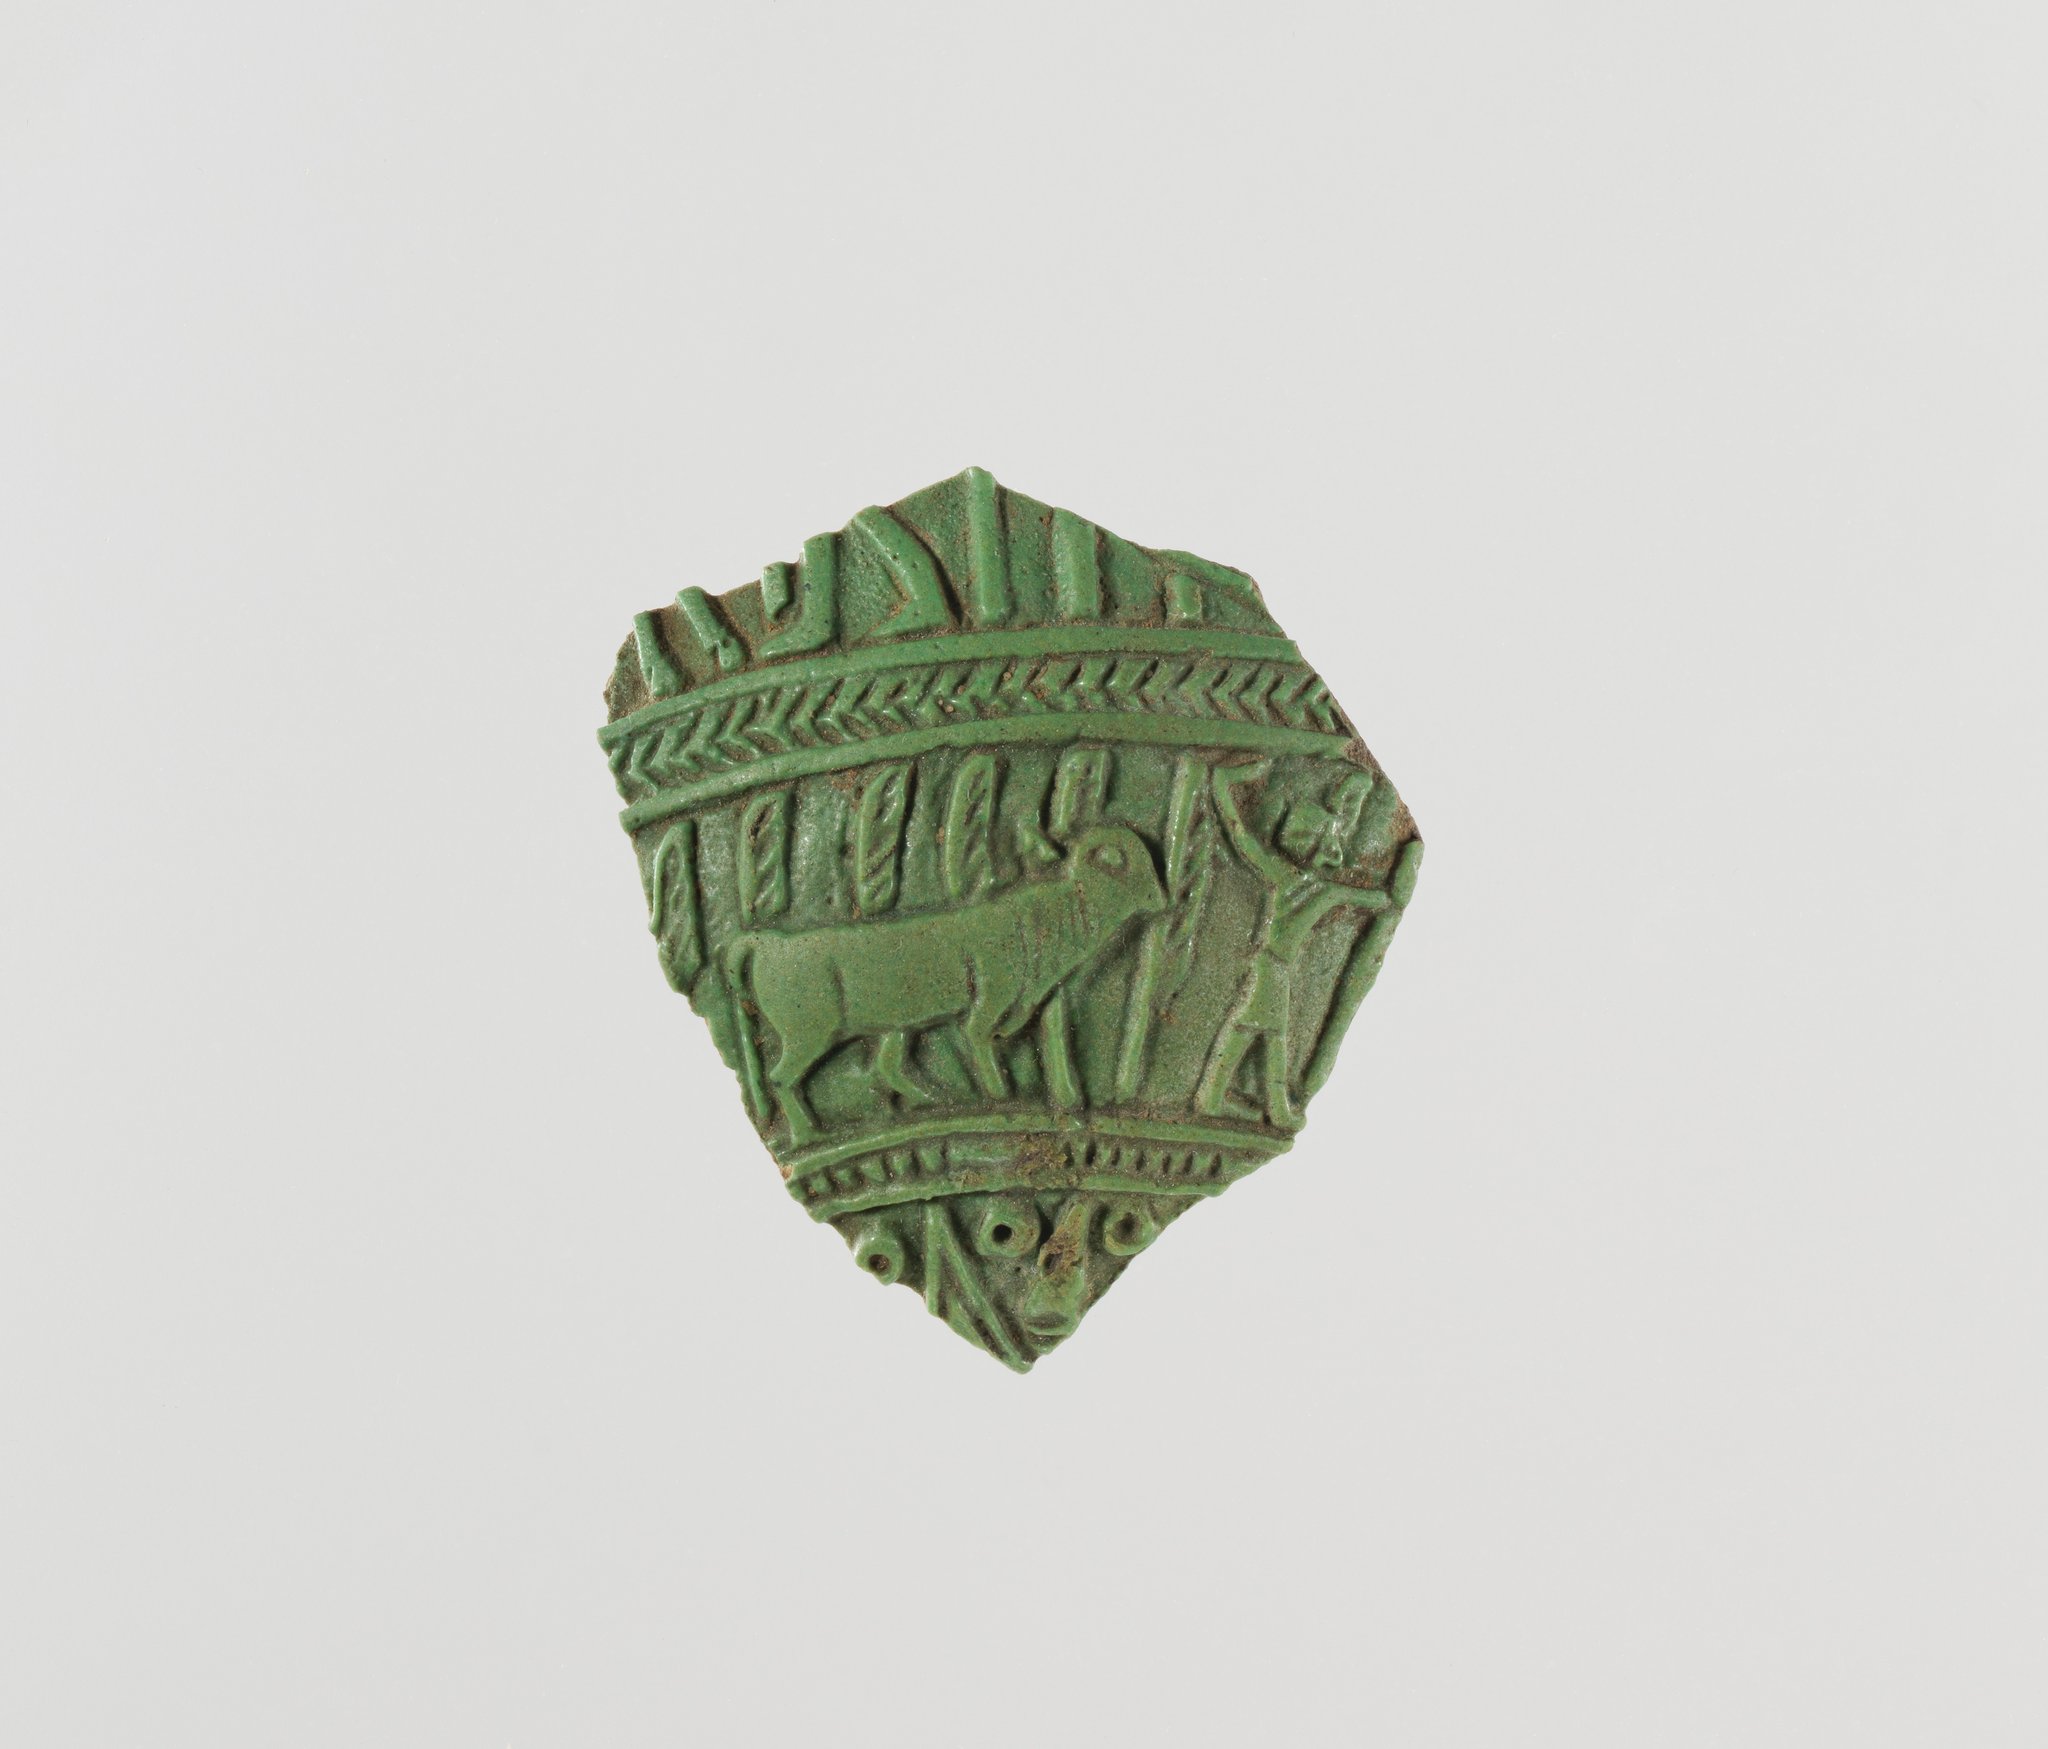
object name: chalice, cup, lotiform, relief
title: Lower part of a vessel showing scene with boat, man, and cow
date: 1070-664 BCE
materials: faience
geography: egypt